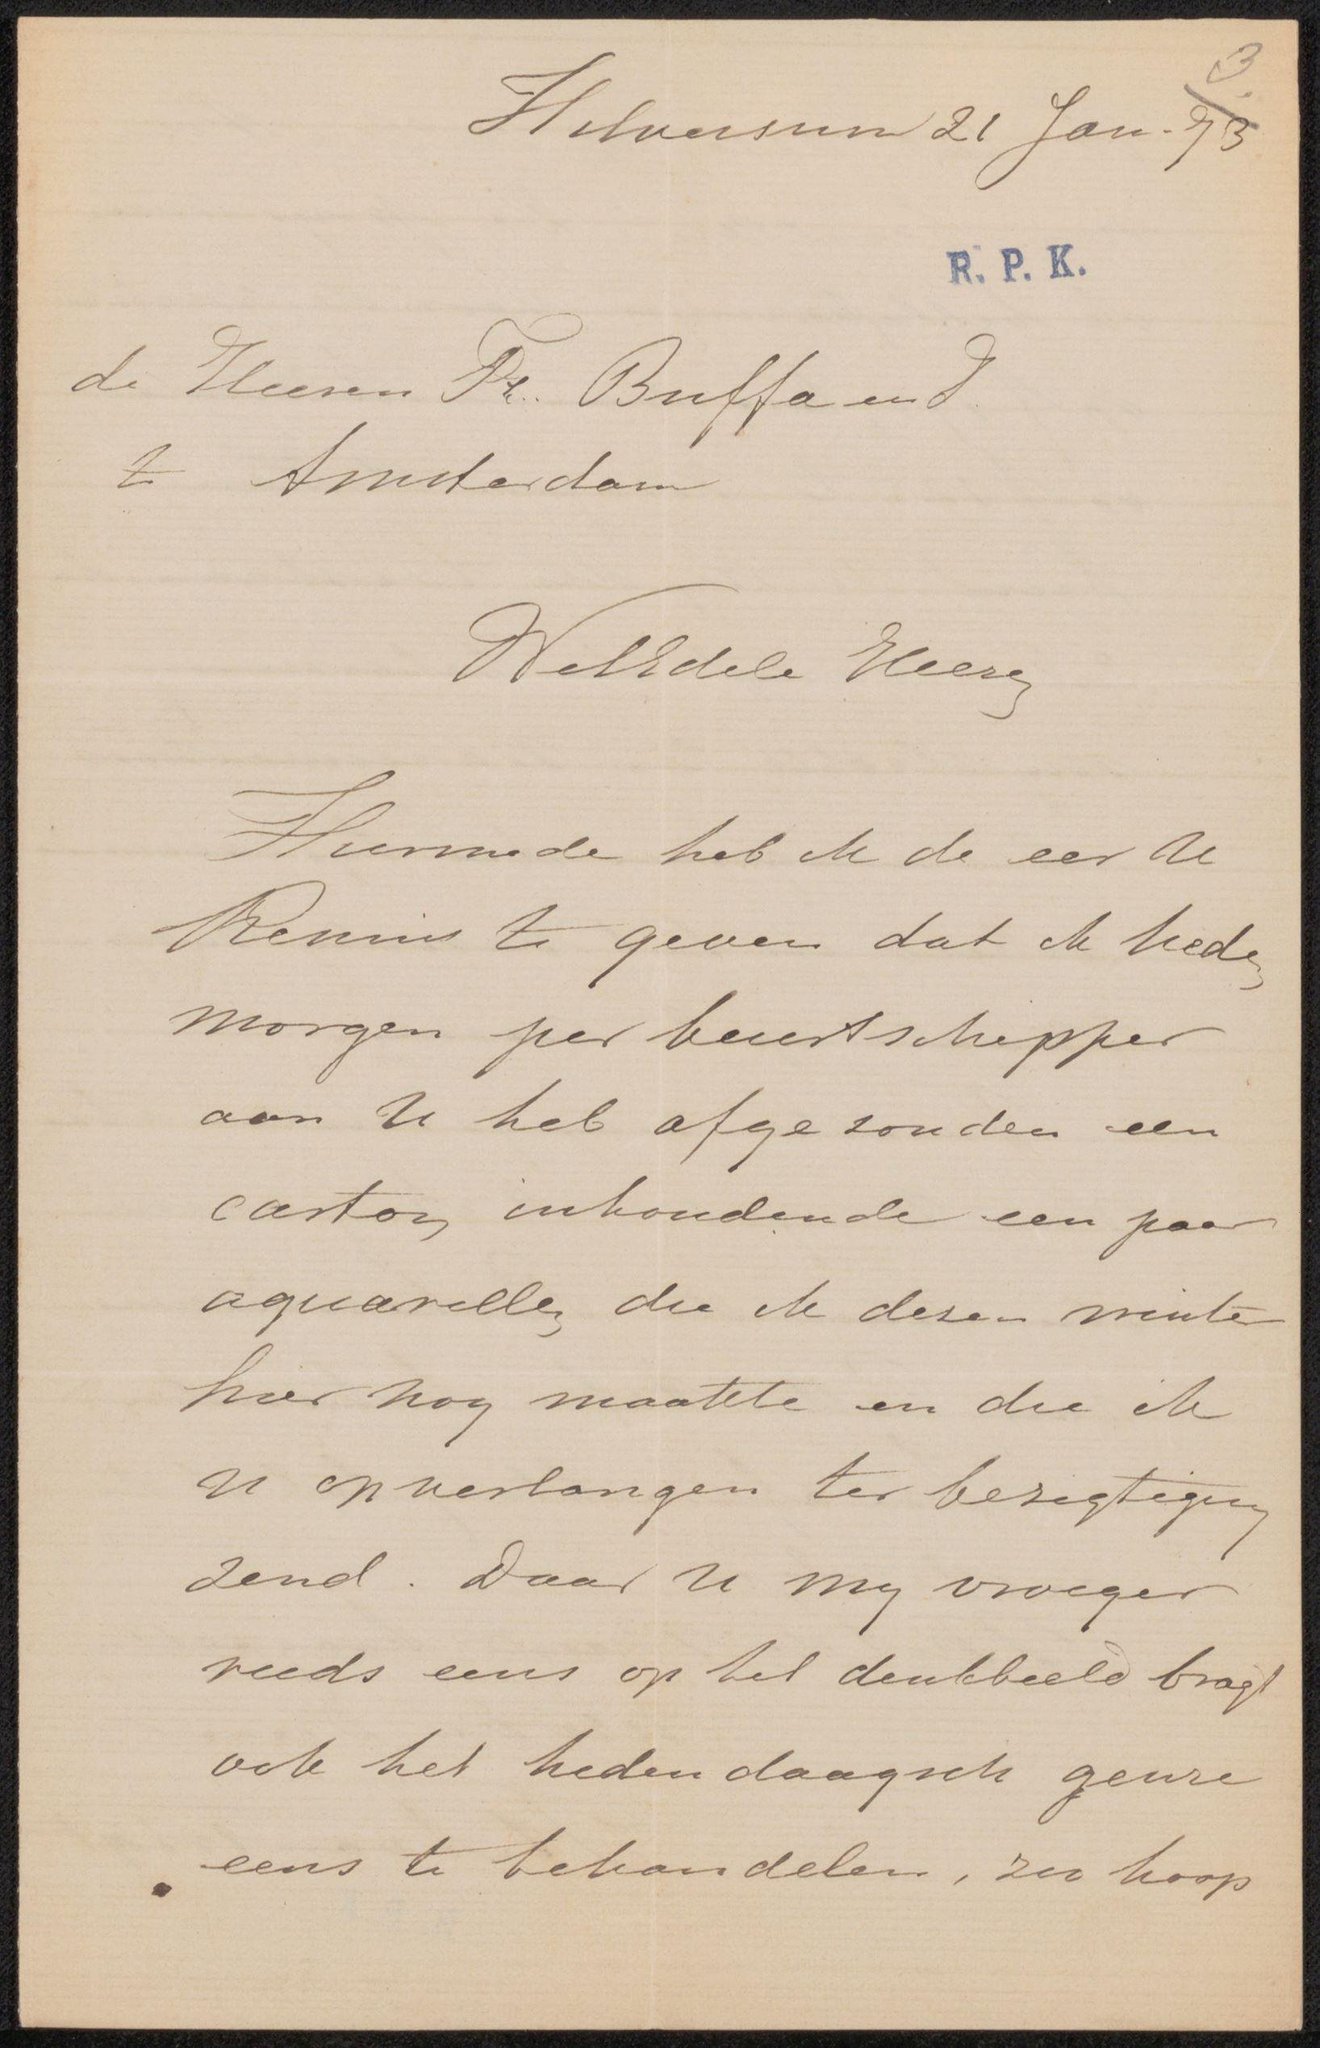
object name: letter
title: Brief aan Frans Buffa en Zonen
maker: hendrik albert van trigt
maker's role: draughtsman, painter, print maker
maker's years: 1829-1899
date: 1873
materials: ink, paper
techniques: pen, writing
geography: hilversum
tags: publisher, william unger, art trade, art shop, drawing, the graphic arts, money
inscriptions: collector's mark: Lugt 2233